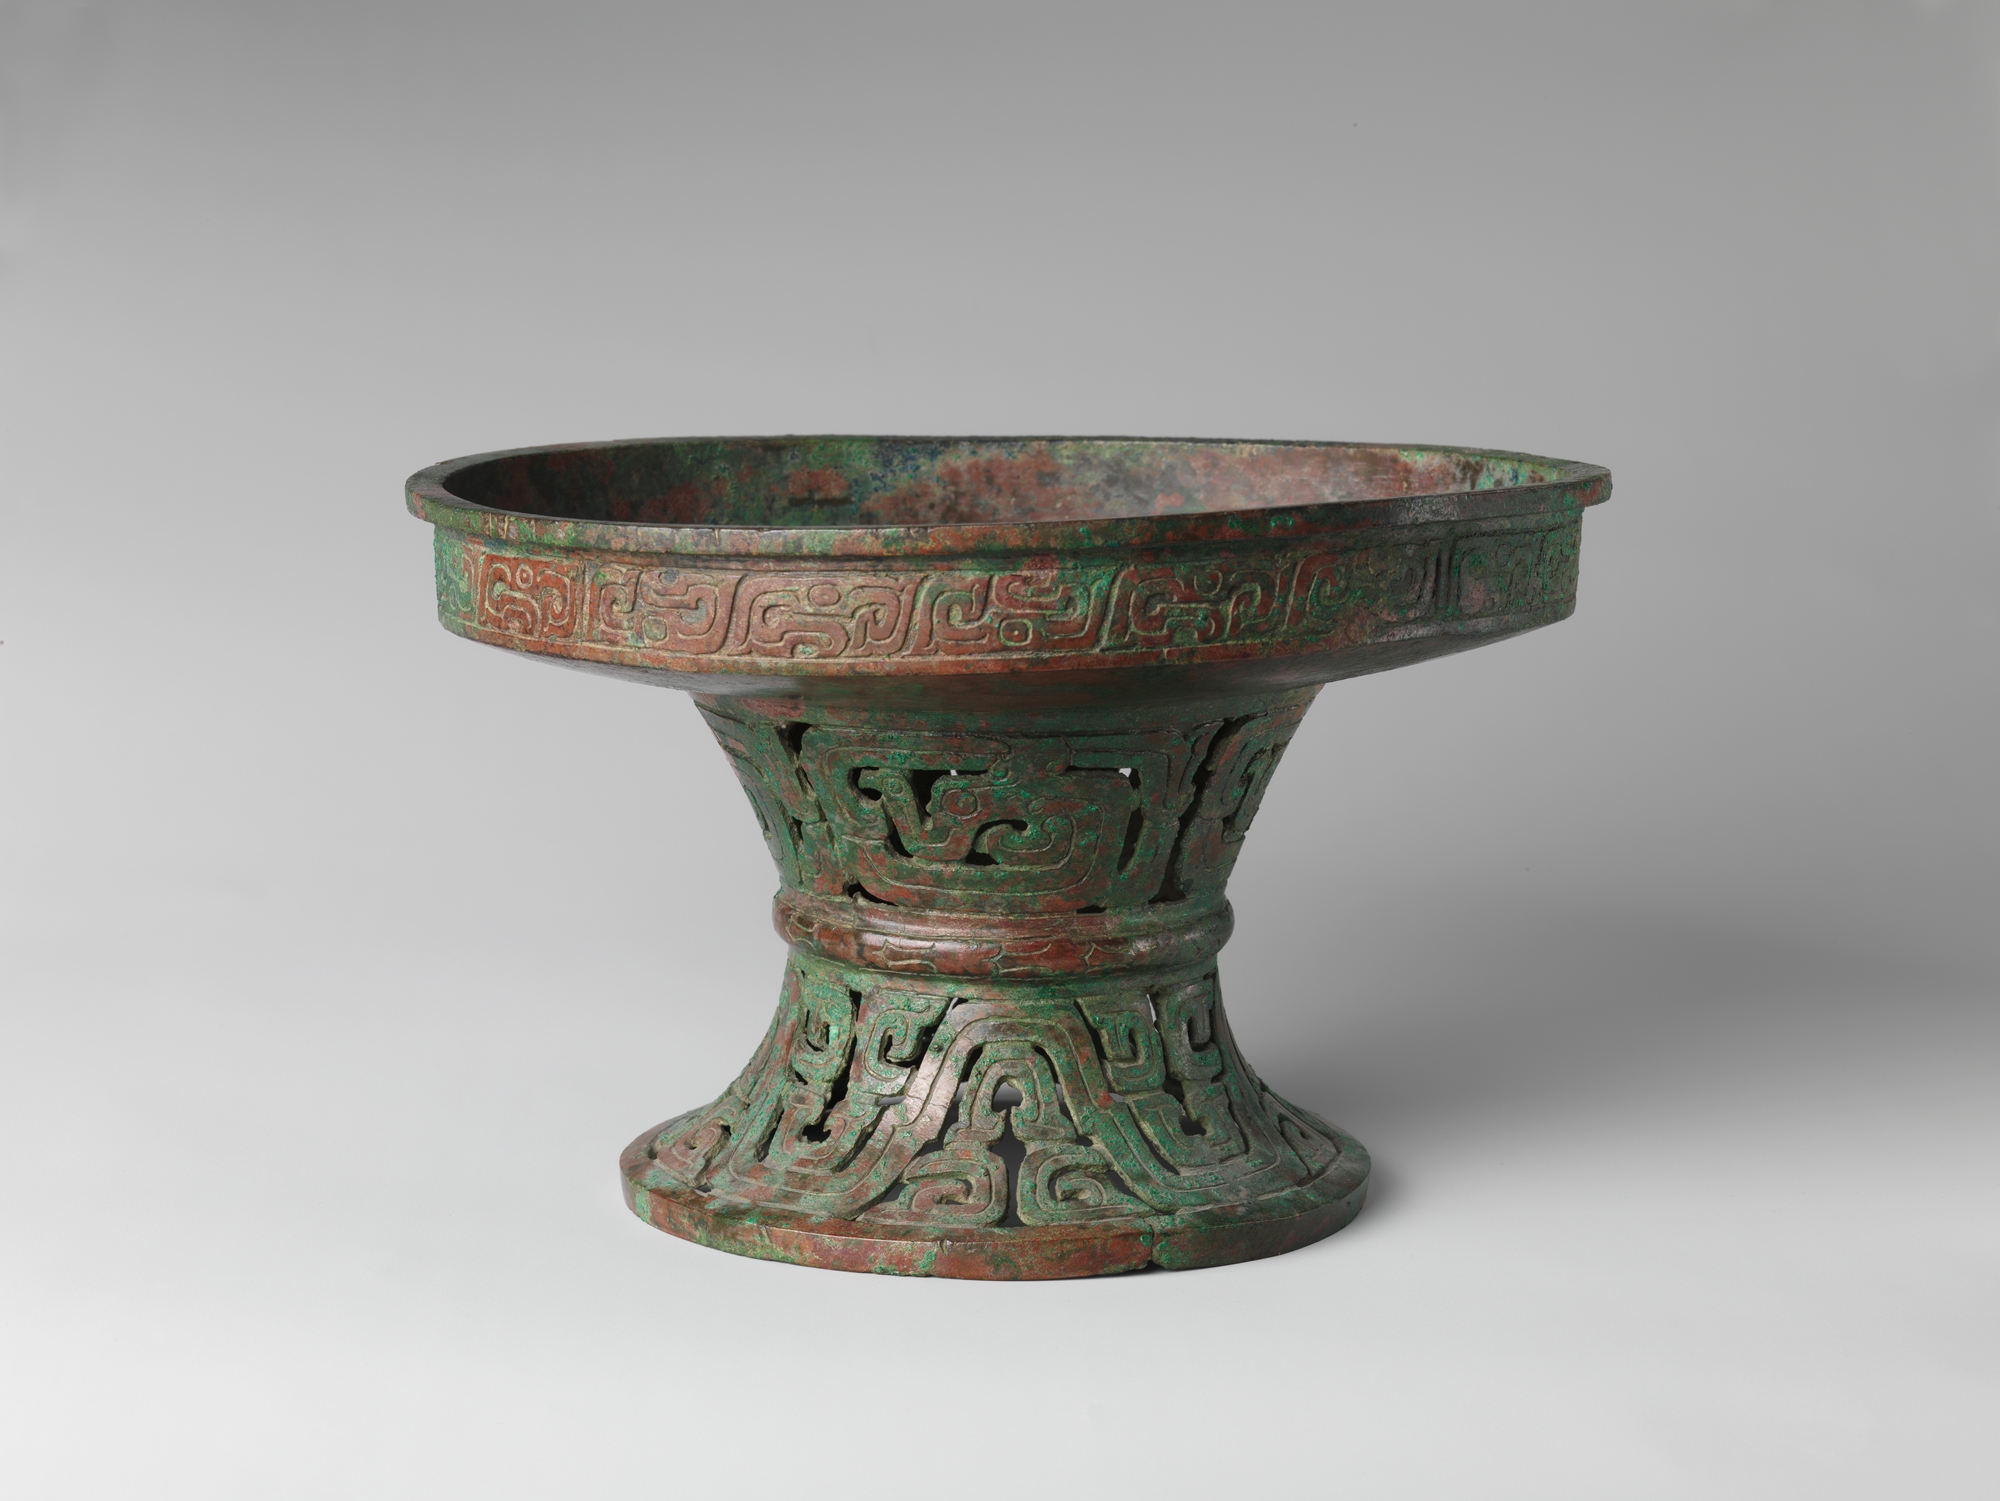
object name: food vessel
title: Food serving vessel (Pu)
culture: chinese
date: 834-768 BCE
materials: bronze